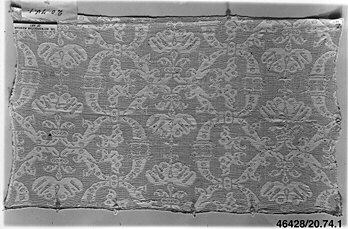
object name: piece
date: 1601-1633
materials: linen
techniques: embroidery